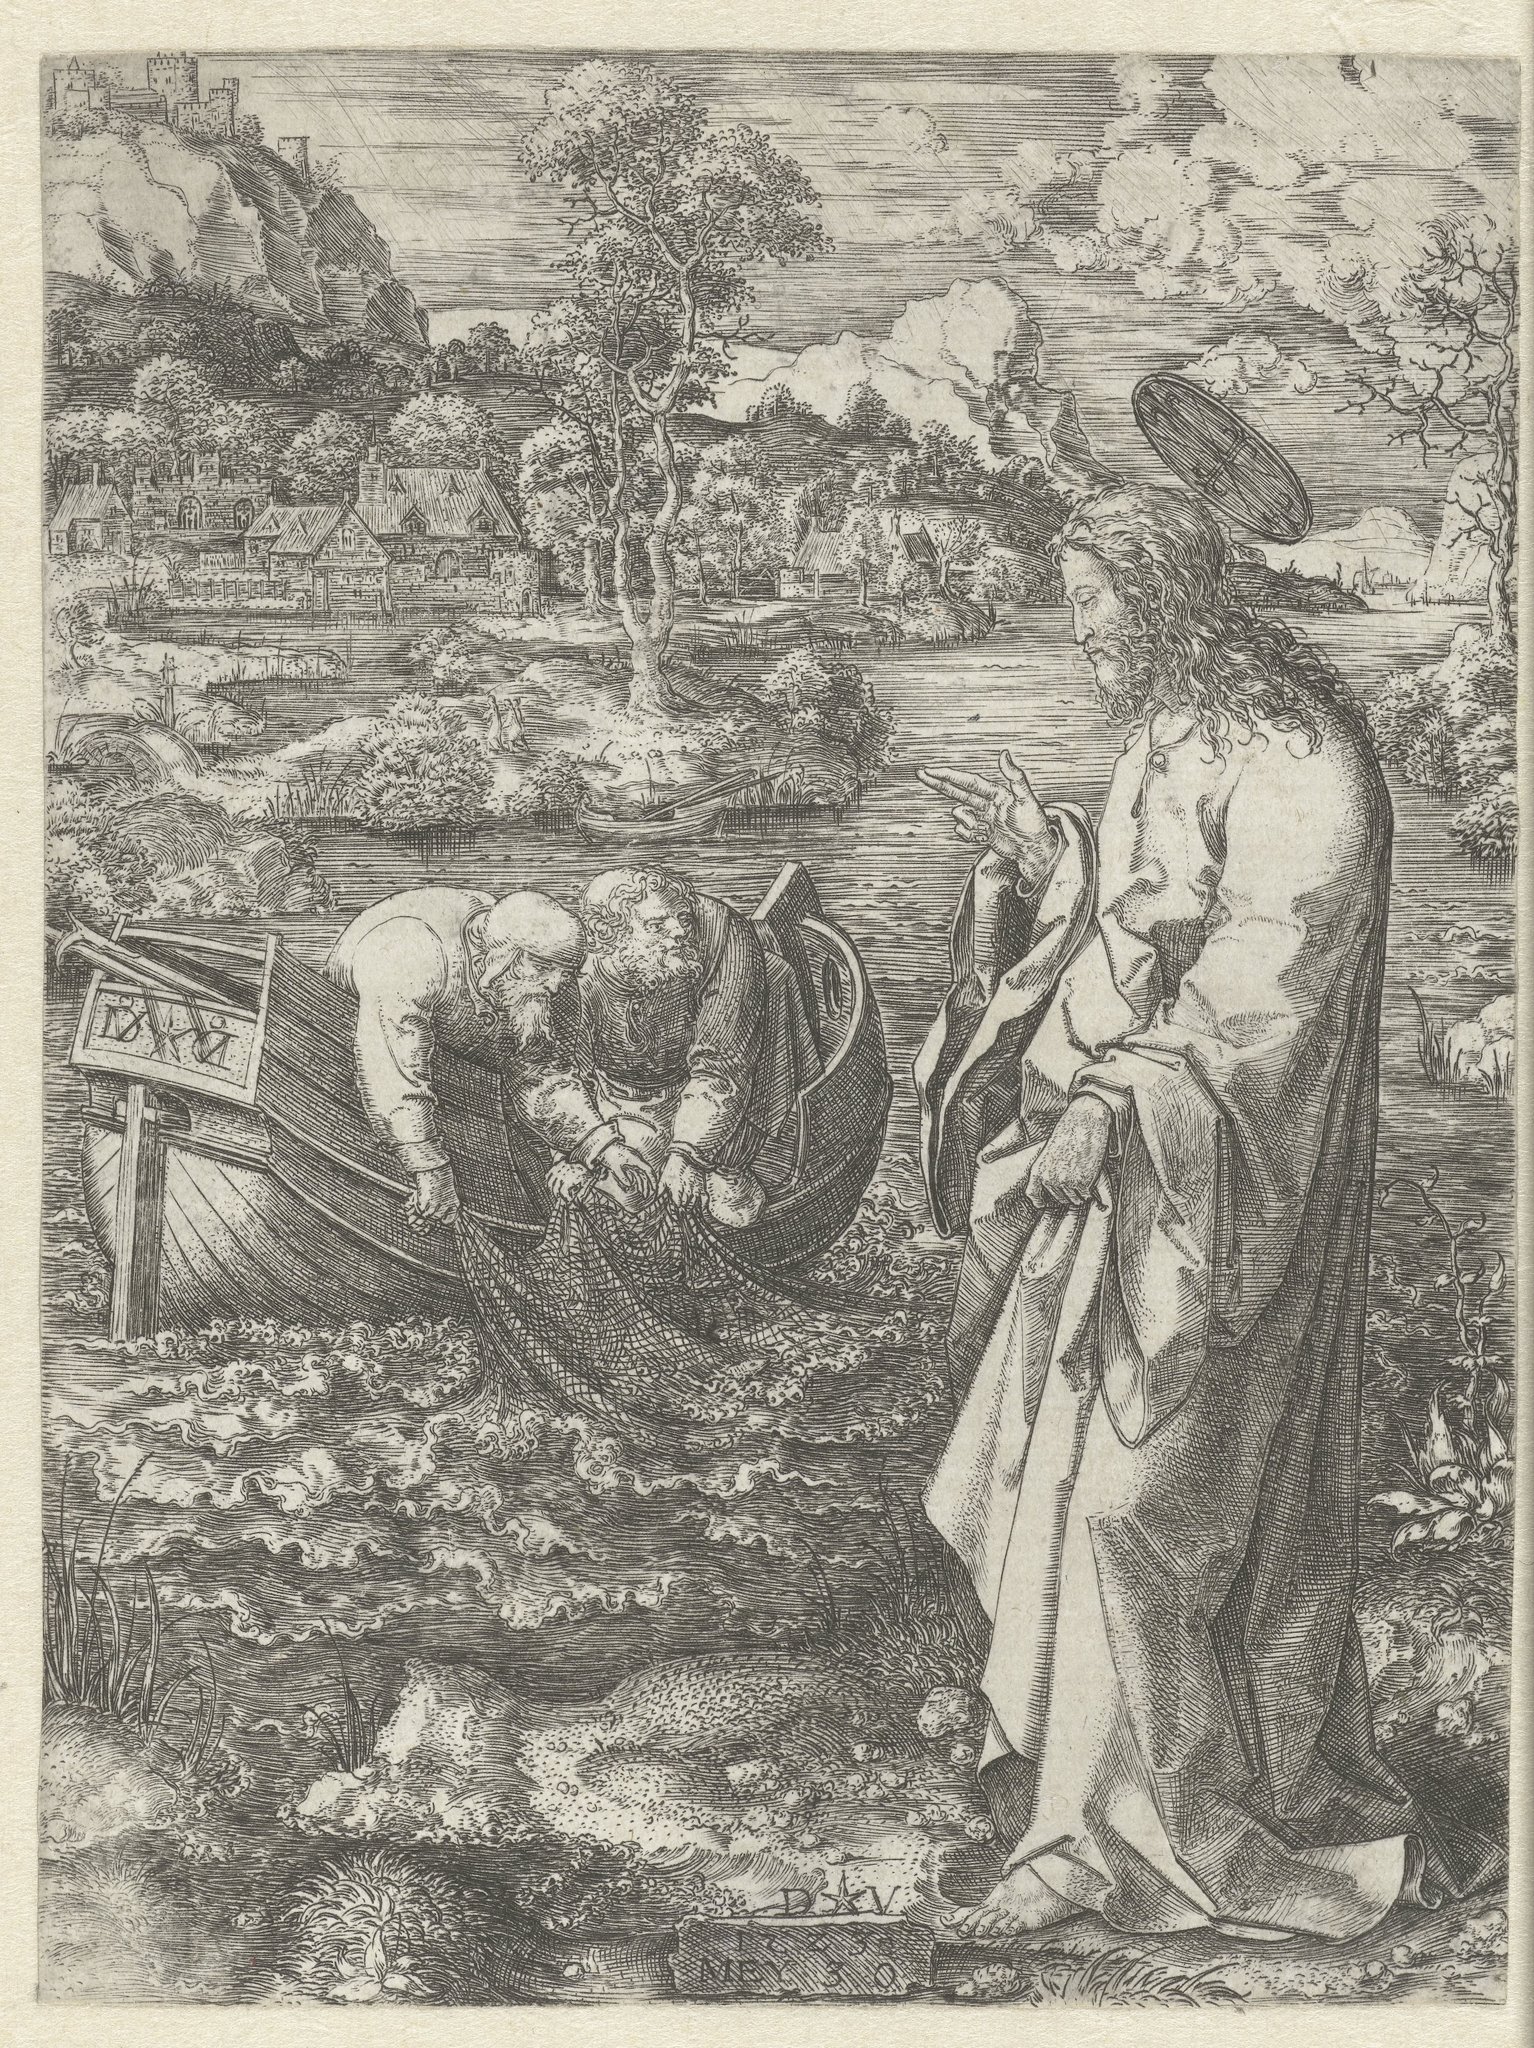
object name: print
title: Roeping van Petrus en Andreas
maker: dirck vellert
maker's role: draughtsman, painter, print maker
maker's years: 1480-1547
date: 1523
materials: paper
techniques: engraving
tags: calling of peter and andrew; they are called away from their fishing-boat (matthew 4:18-20; mark 1:16-18)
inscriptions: collector's mark: Lugt 2228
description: Landschap met rivier. Petrus en Andreas in boot met visnet. Christus op de wal.